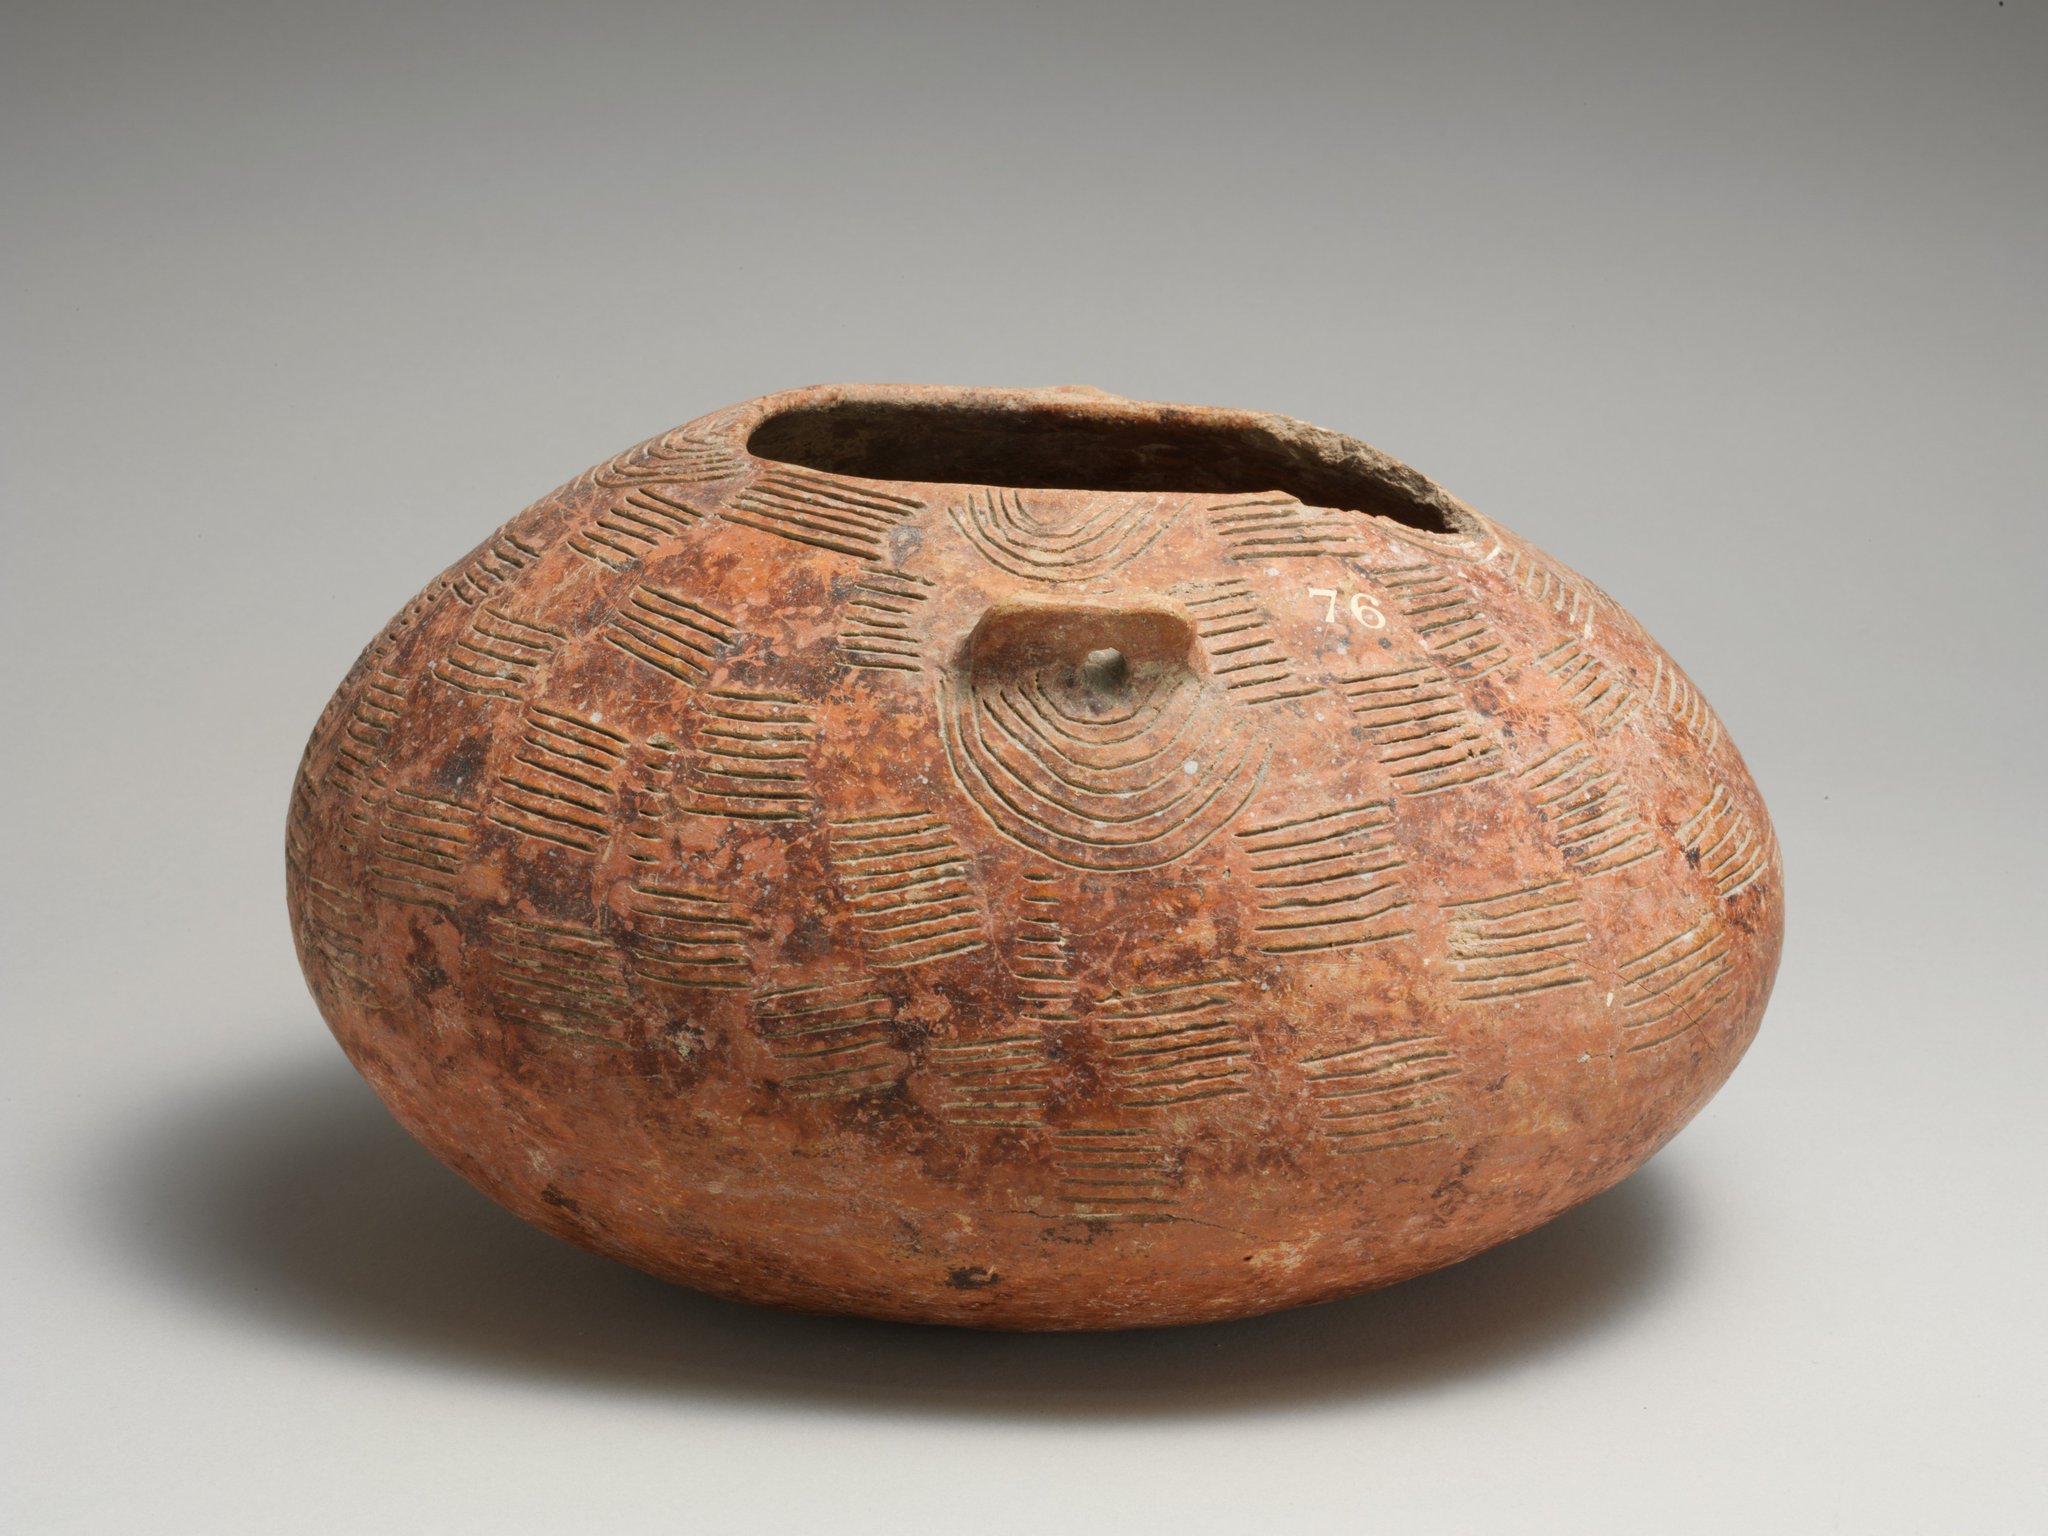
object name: pyxis with lid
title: Terracotta pyxis (container) with lid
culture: cypriot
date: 2500-1900 BCE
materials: terracotta